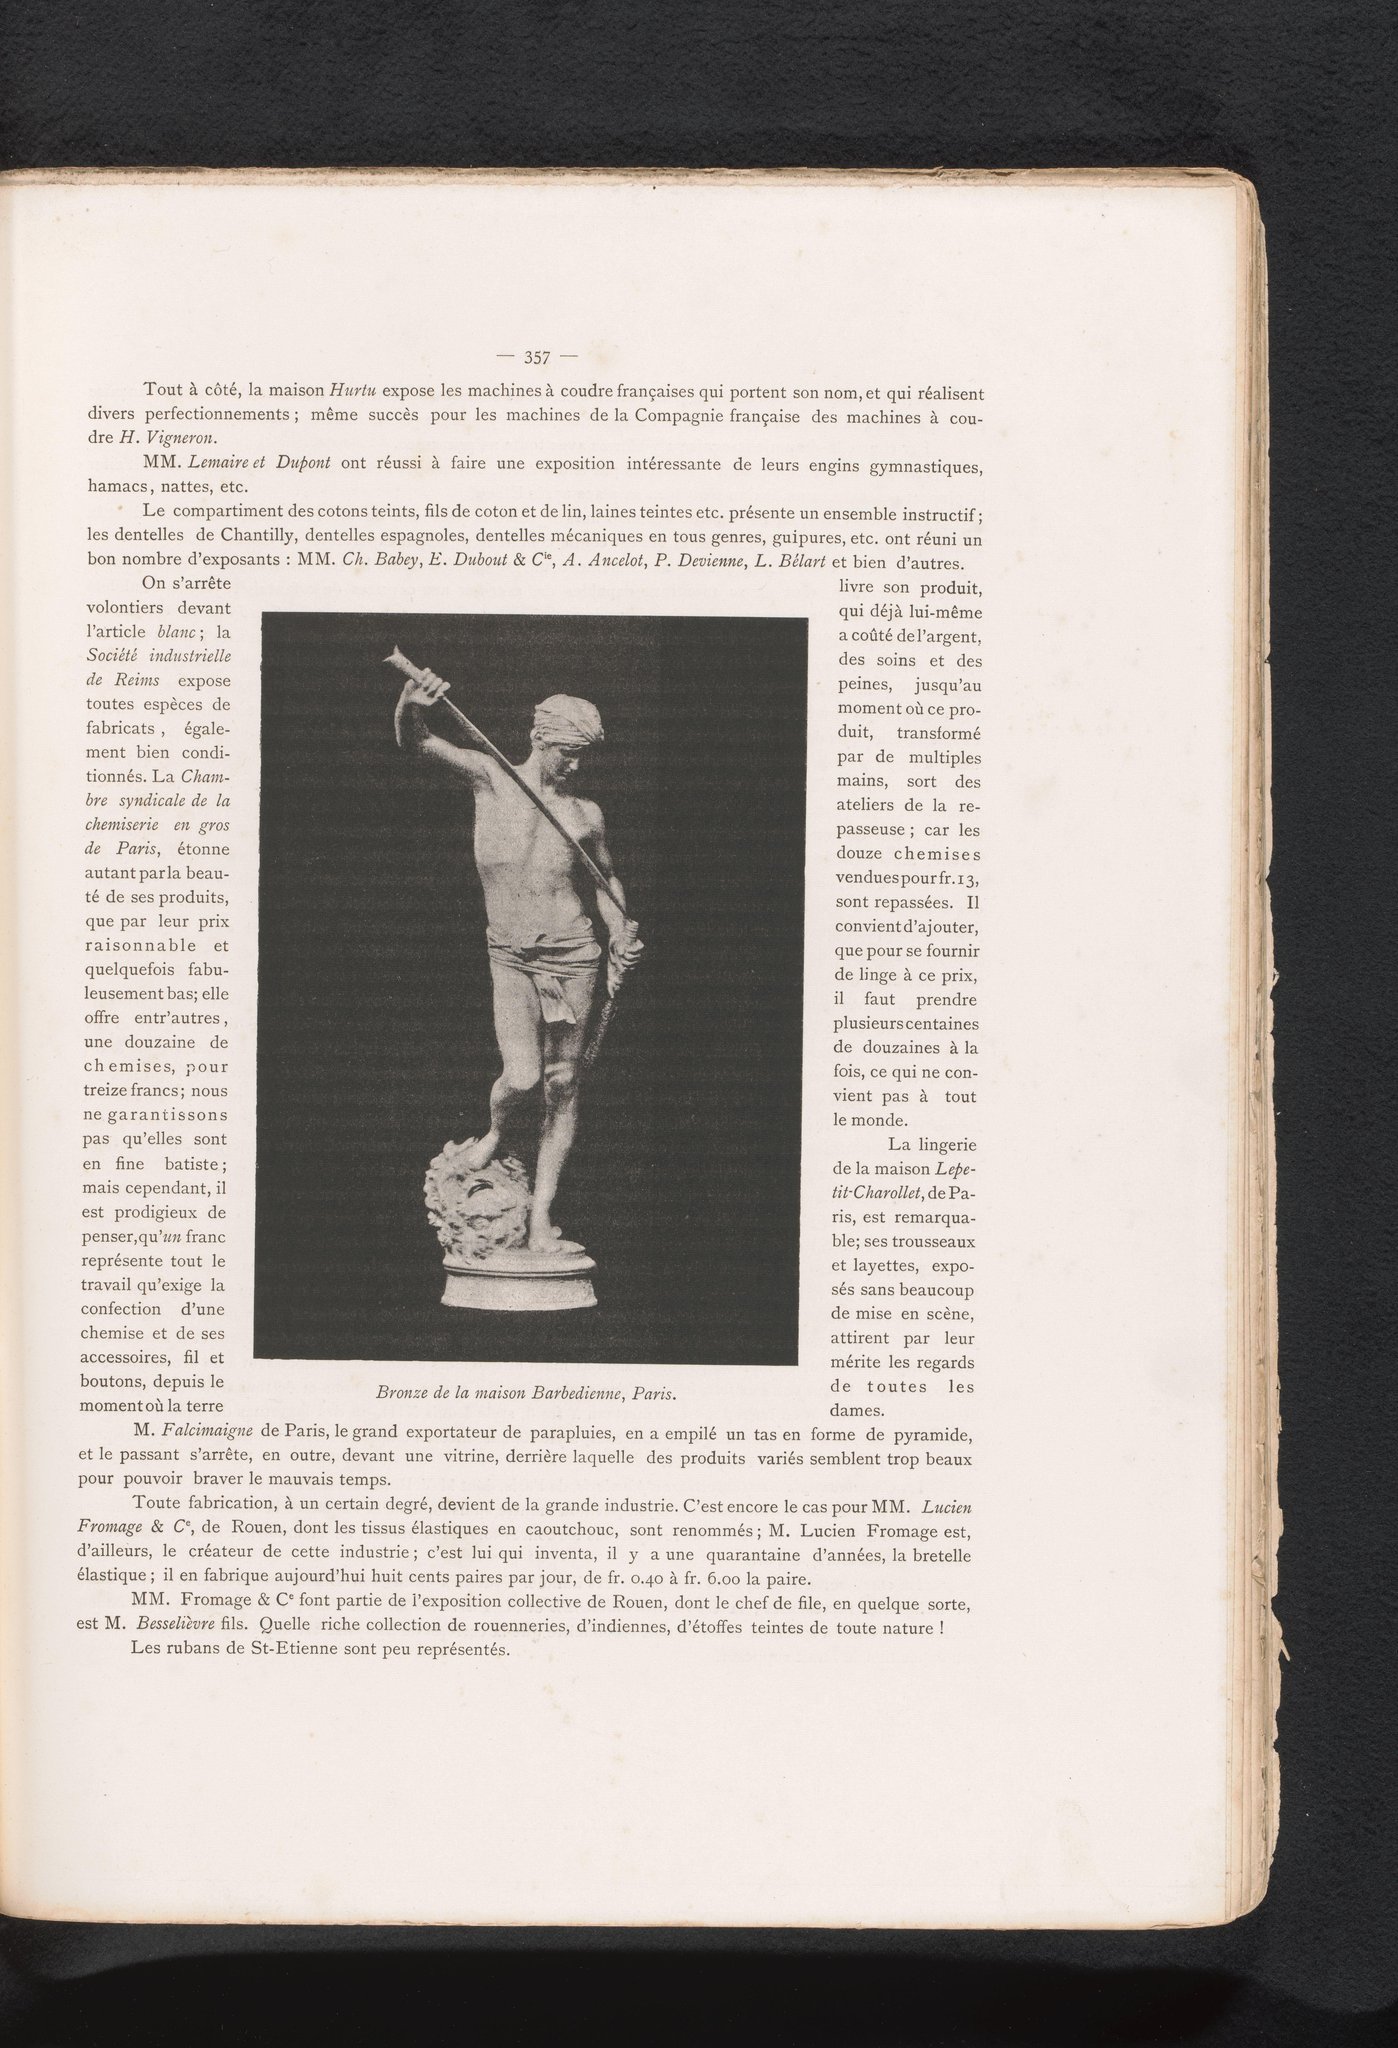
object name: page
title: Bronze de la maison Barbedienne, Paris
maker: Anonymous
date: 1880-1885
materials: paper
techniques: autotype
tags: adult man, piece of sculpture, reproduction of a piece of sculpture